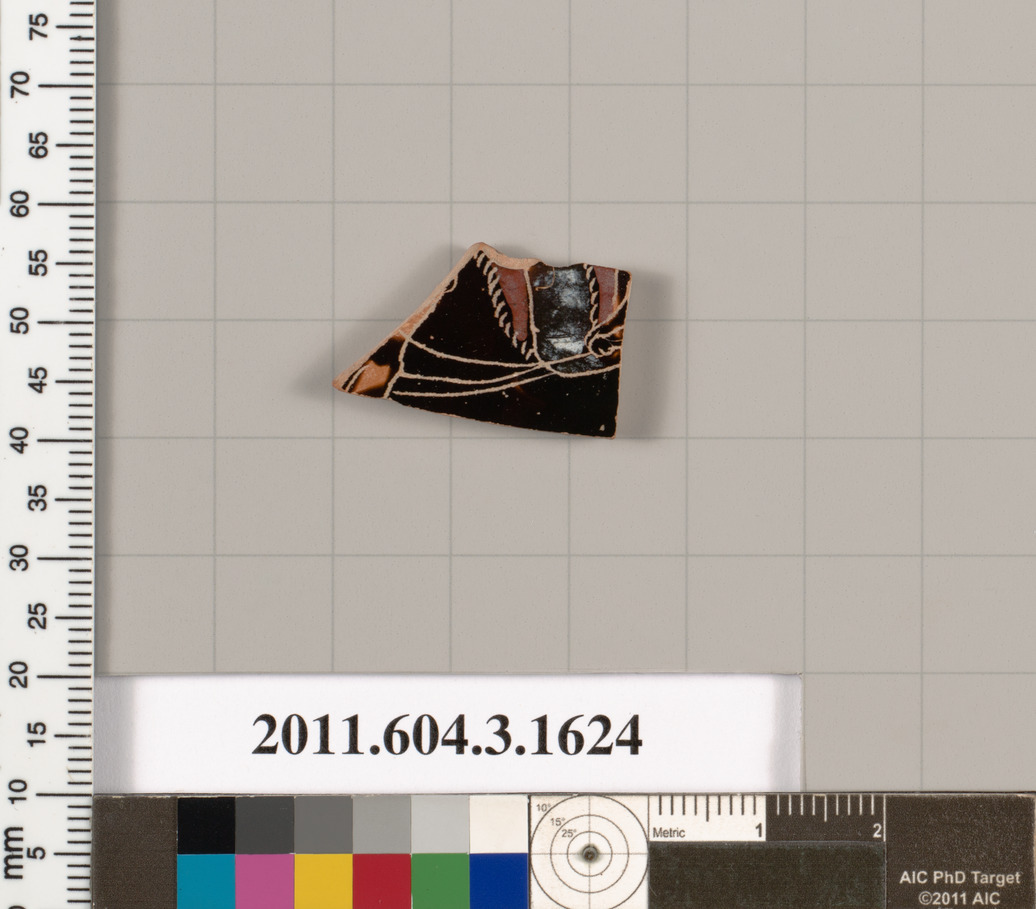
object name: kylix fragment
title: Terracotta fragment of a kylix: Band cup (drinking cup)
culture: greek, attic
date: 567-535 BCE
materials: terracotta